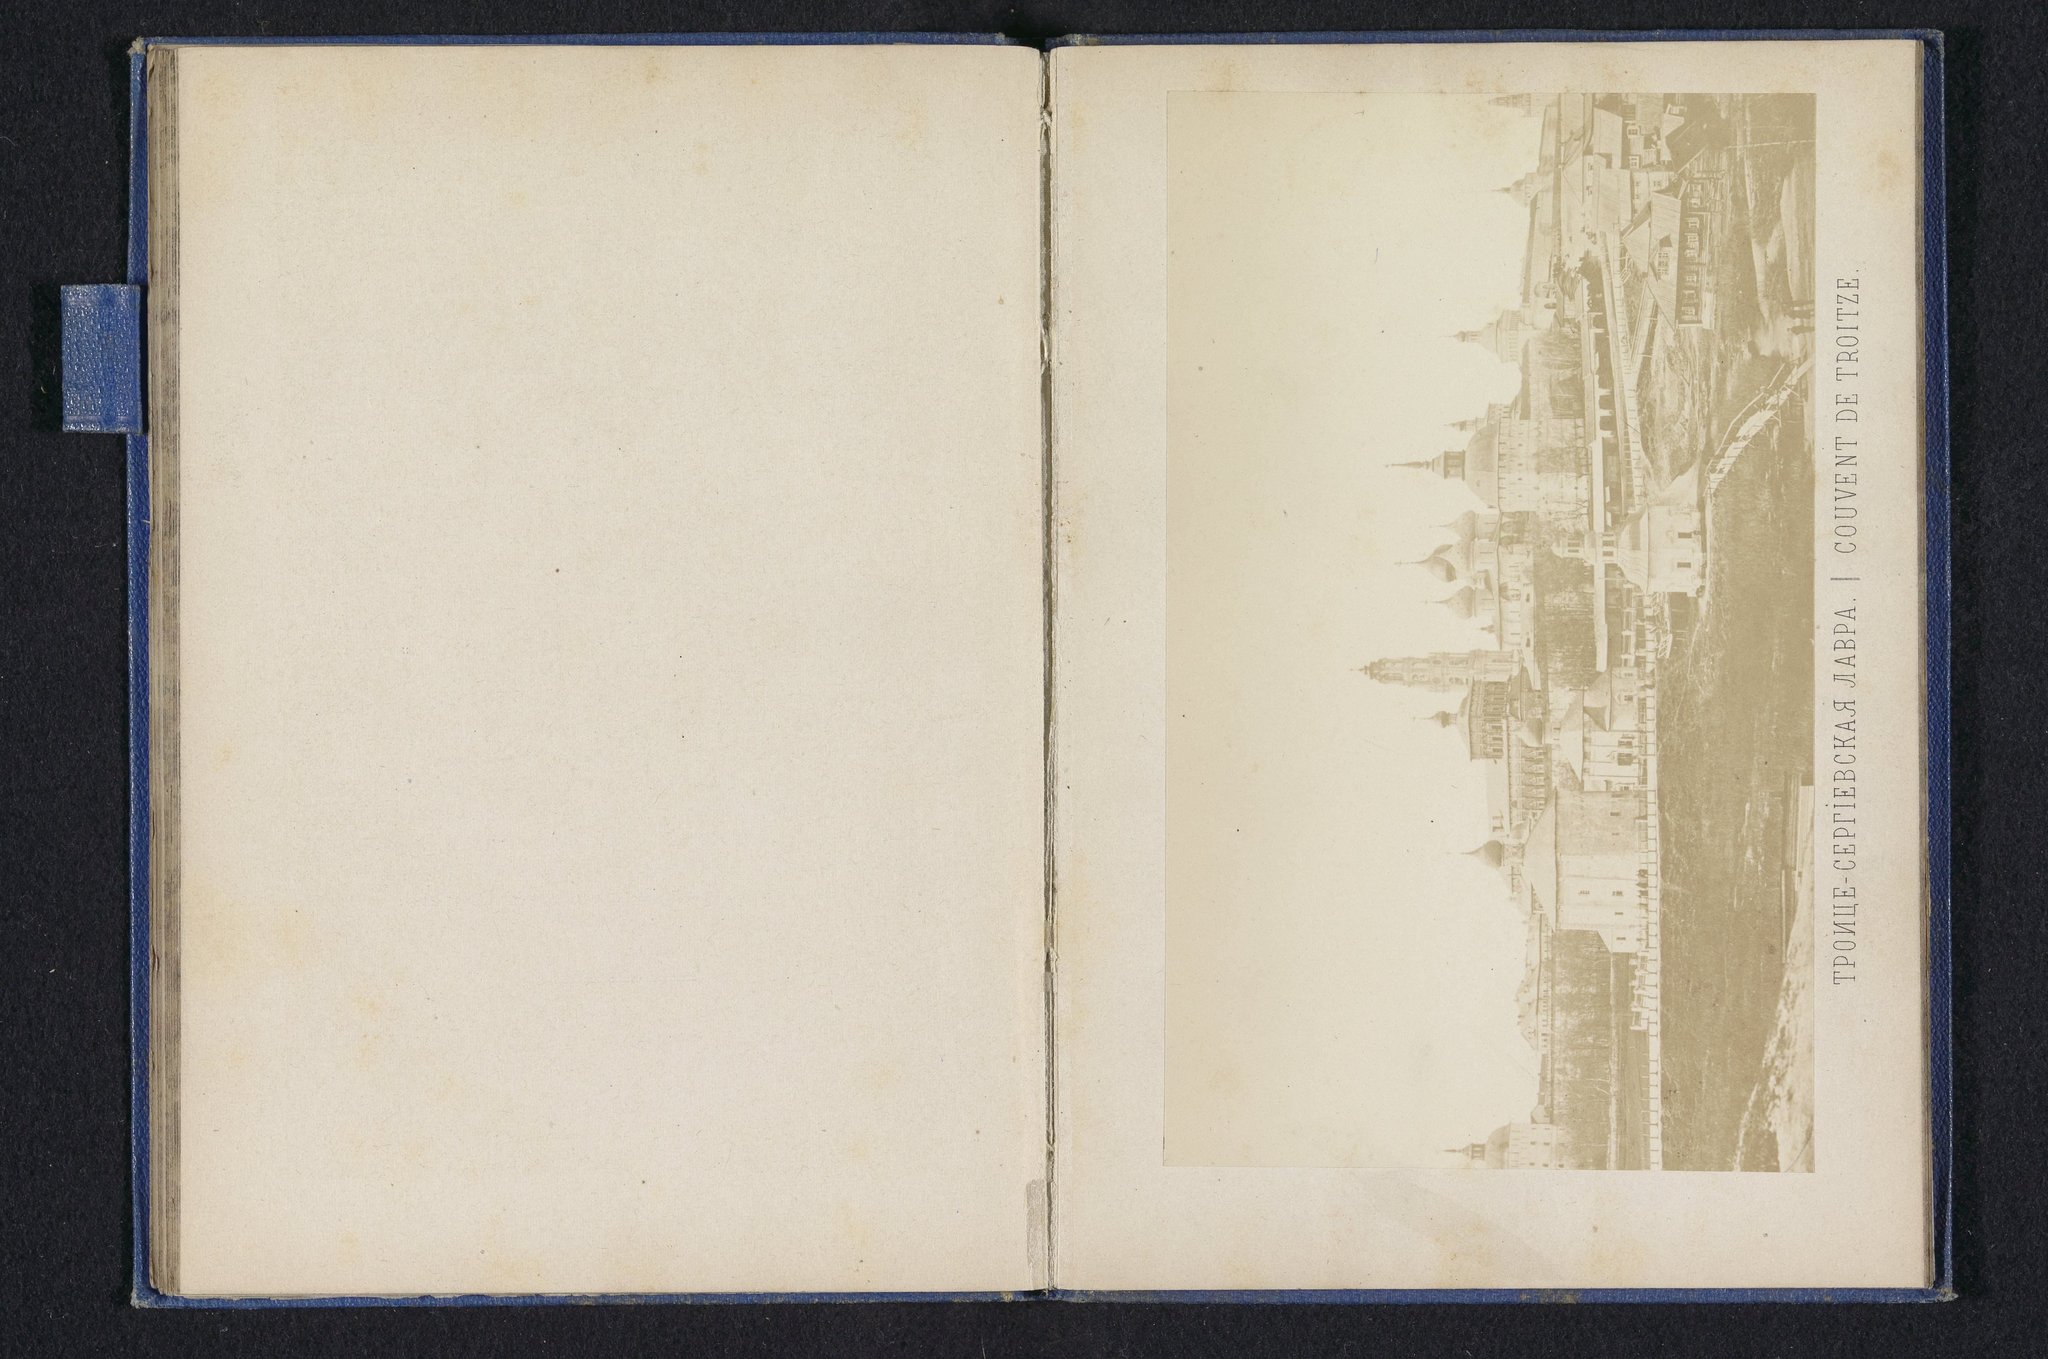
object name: page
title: Couvent de Troitze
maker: Anonymous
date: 1865-1870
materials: photographic support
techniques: albumen print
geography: moscow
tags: abbey, monastery, convent ~ roman catholic church